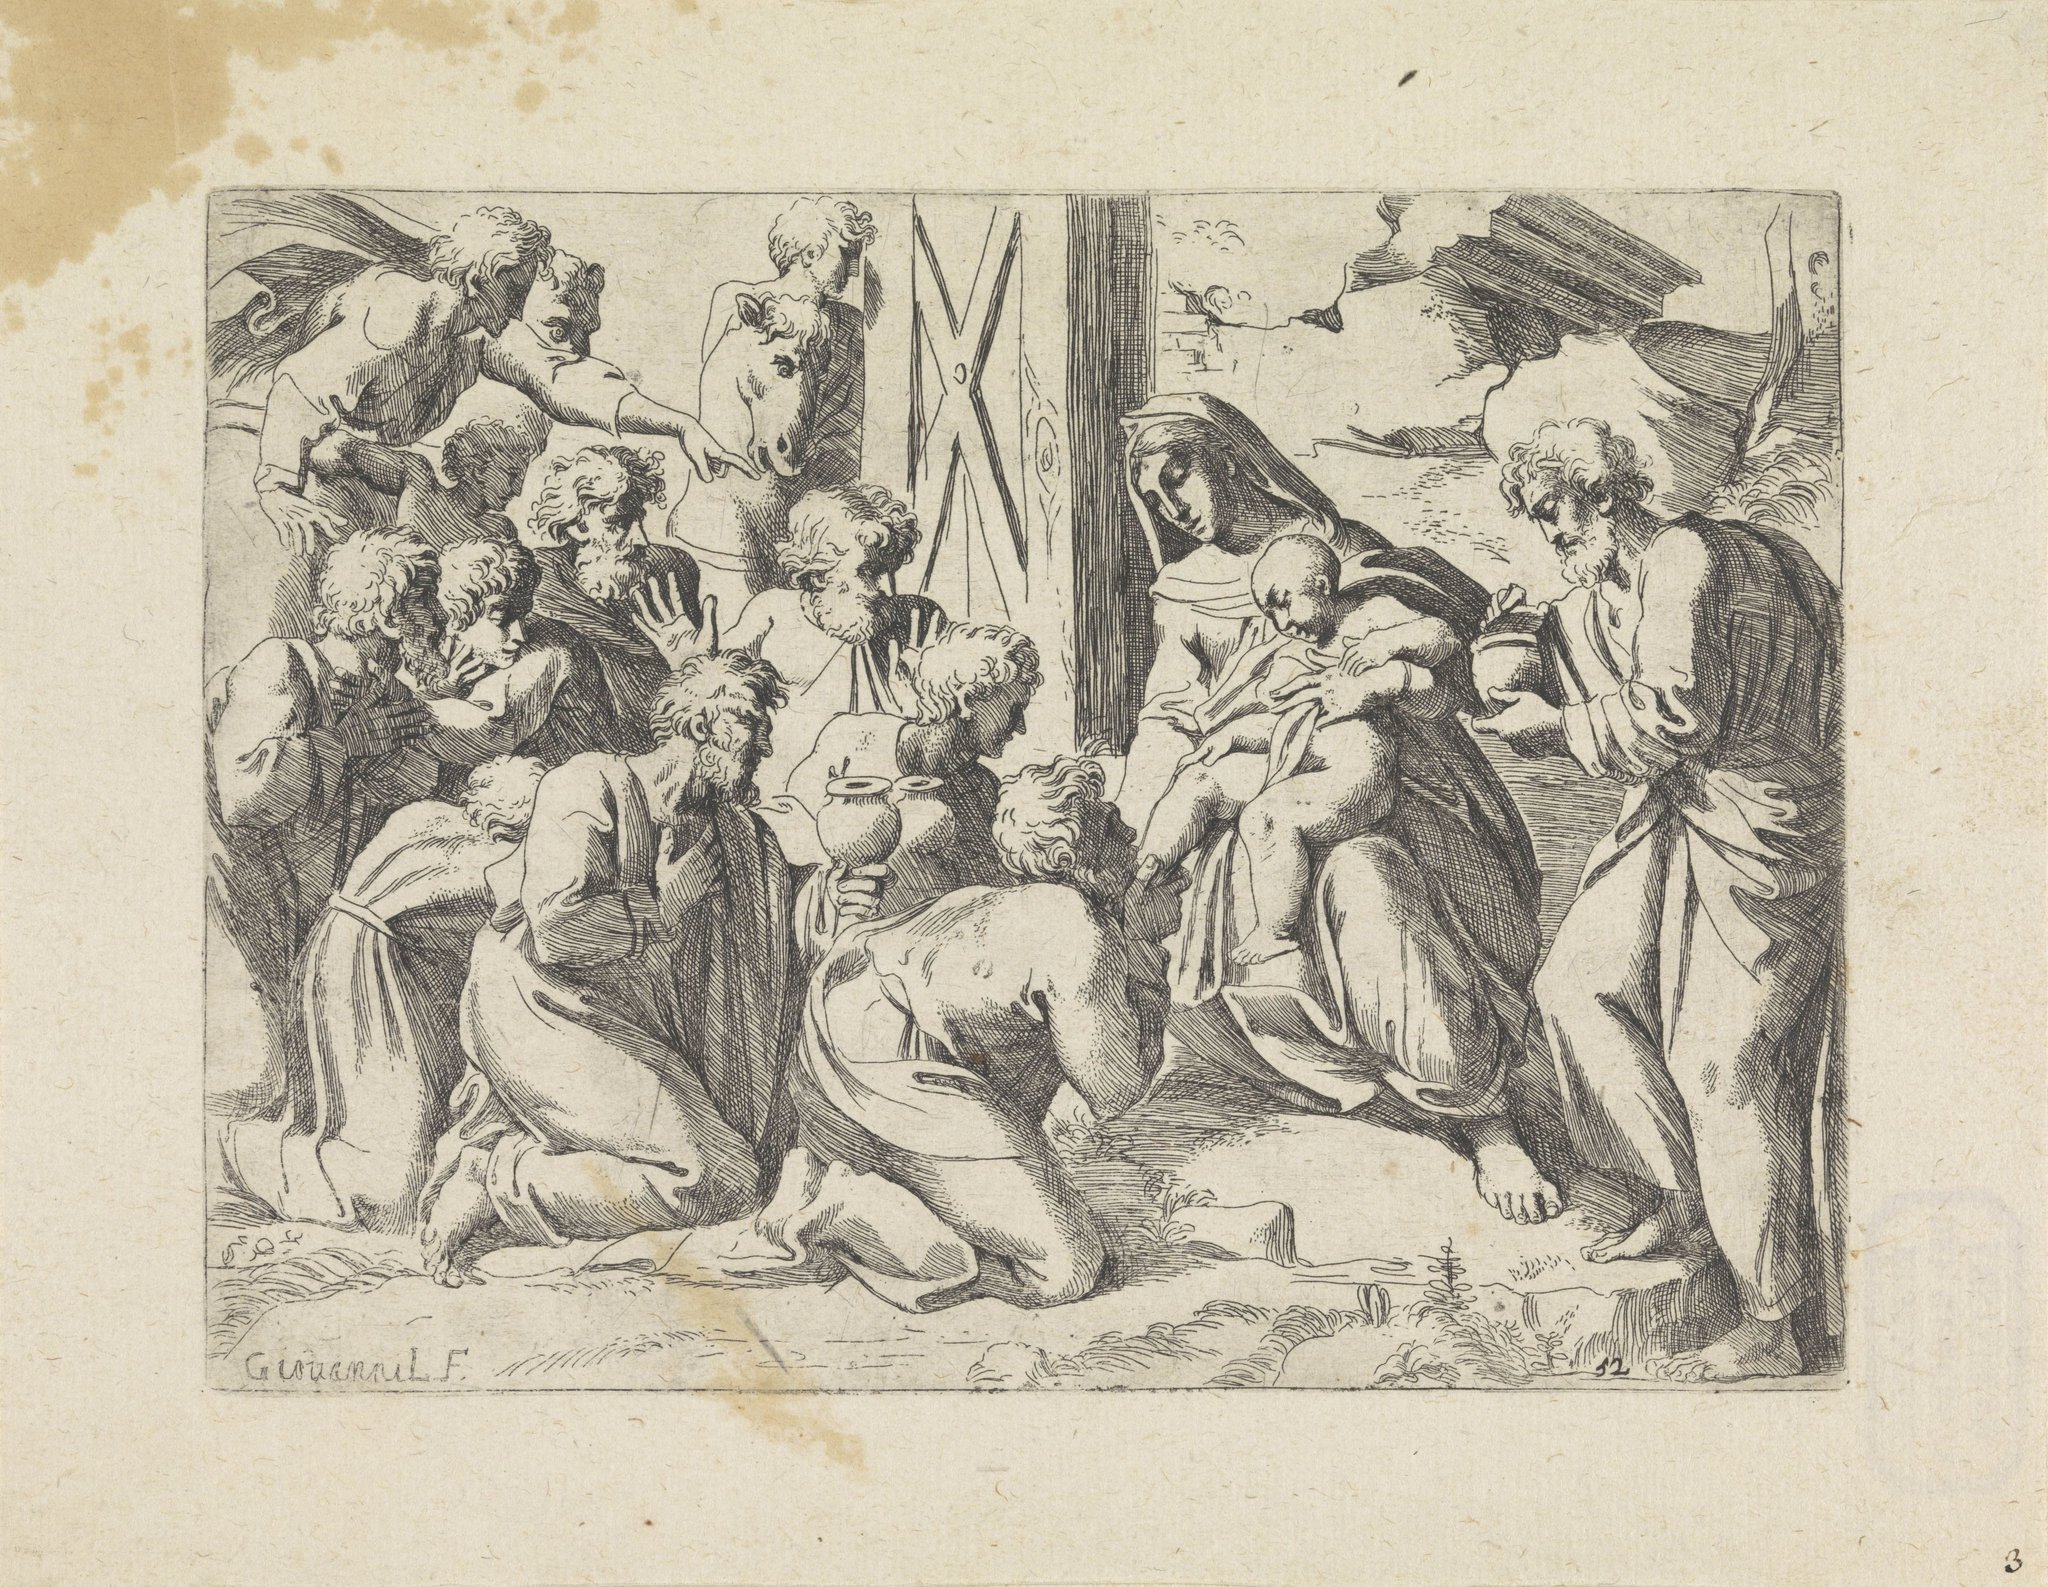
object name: print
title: Bijbelse scènes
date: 1607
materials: paper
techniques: etching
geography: italy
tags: adoration of the kings: the wise men present their gifts to the christ-child (gold, frankincense and myrrh)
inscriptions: number: ‘3’, collector's mark: Lugt 11, collector's mark: ‘Hinloopen’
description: Op een blad geplakt met rechtsboven handgeschreven in pen in bruin: 123. Prent uit een reeks van 54 genummerde prenten naar schilderingen in de Loggia van Rafael in het Vaticaan.